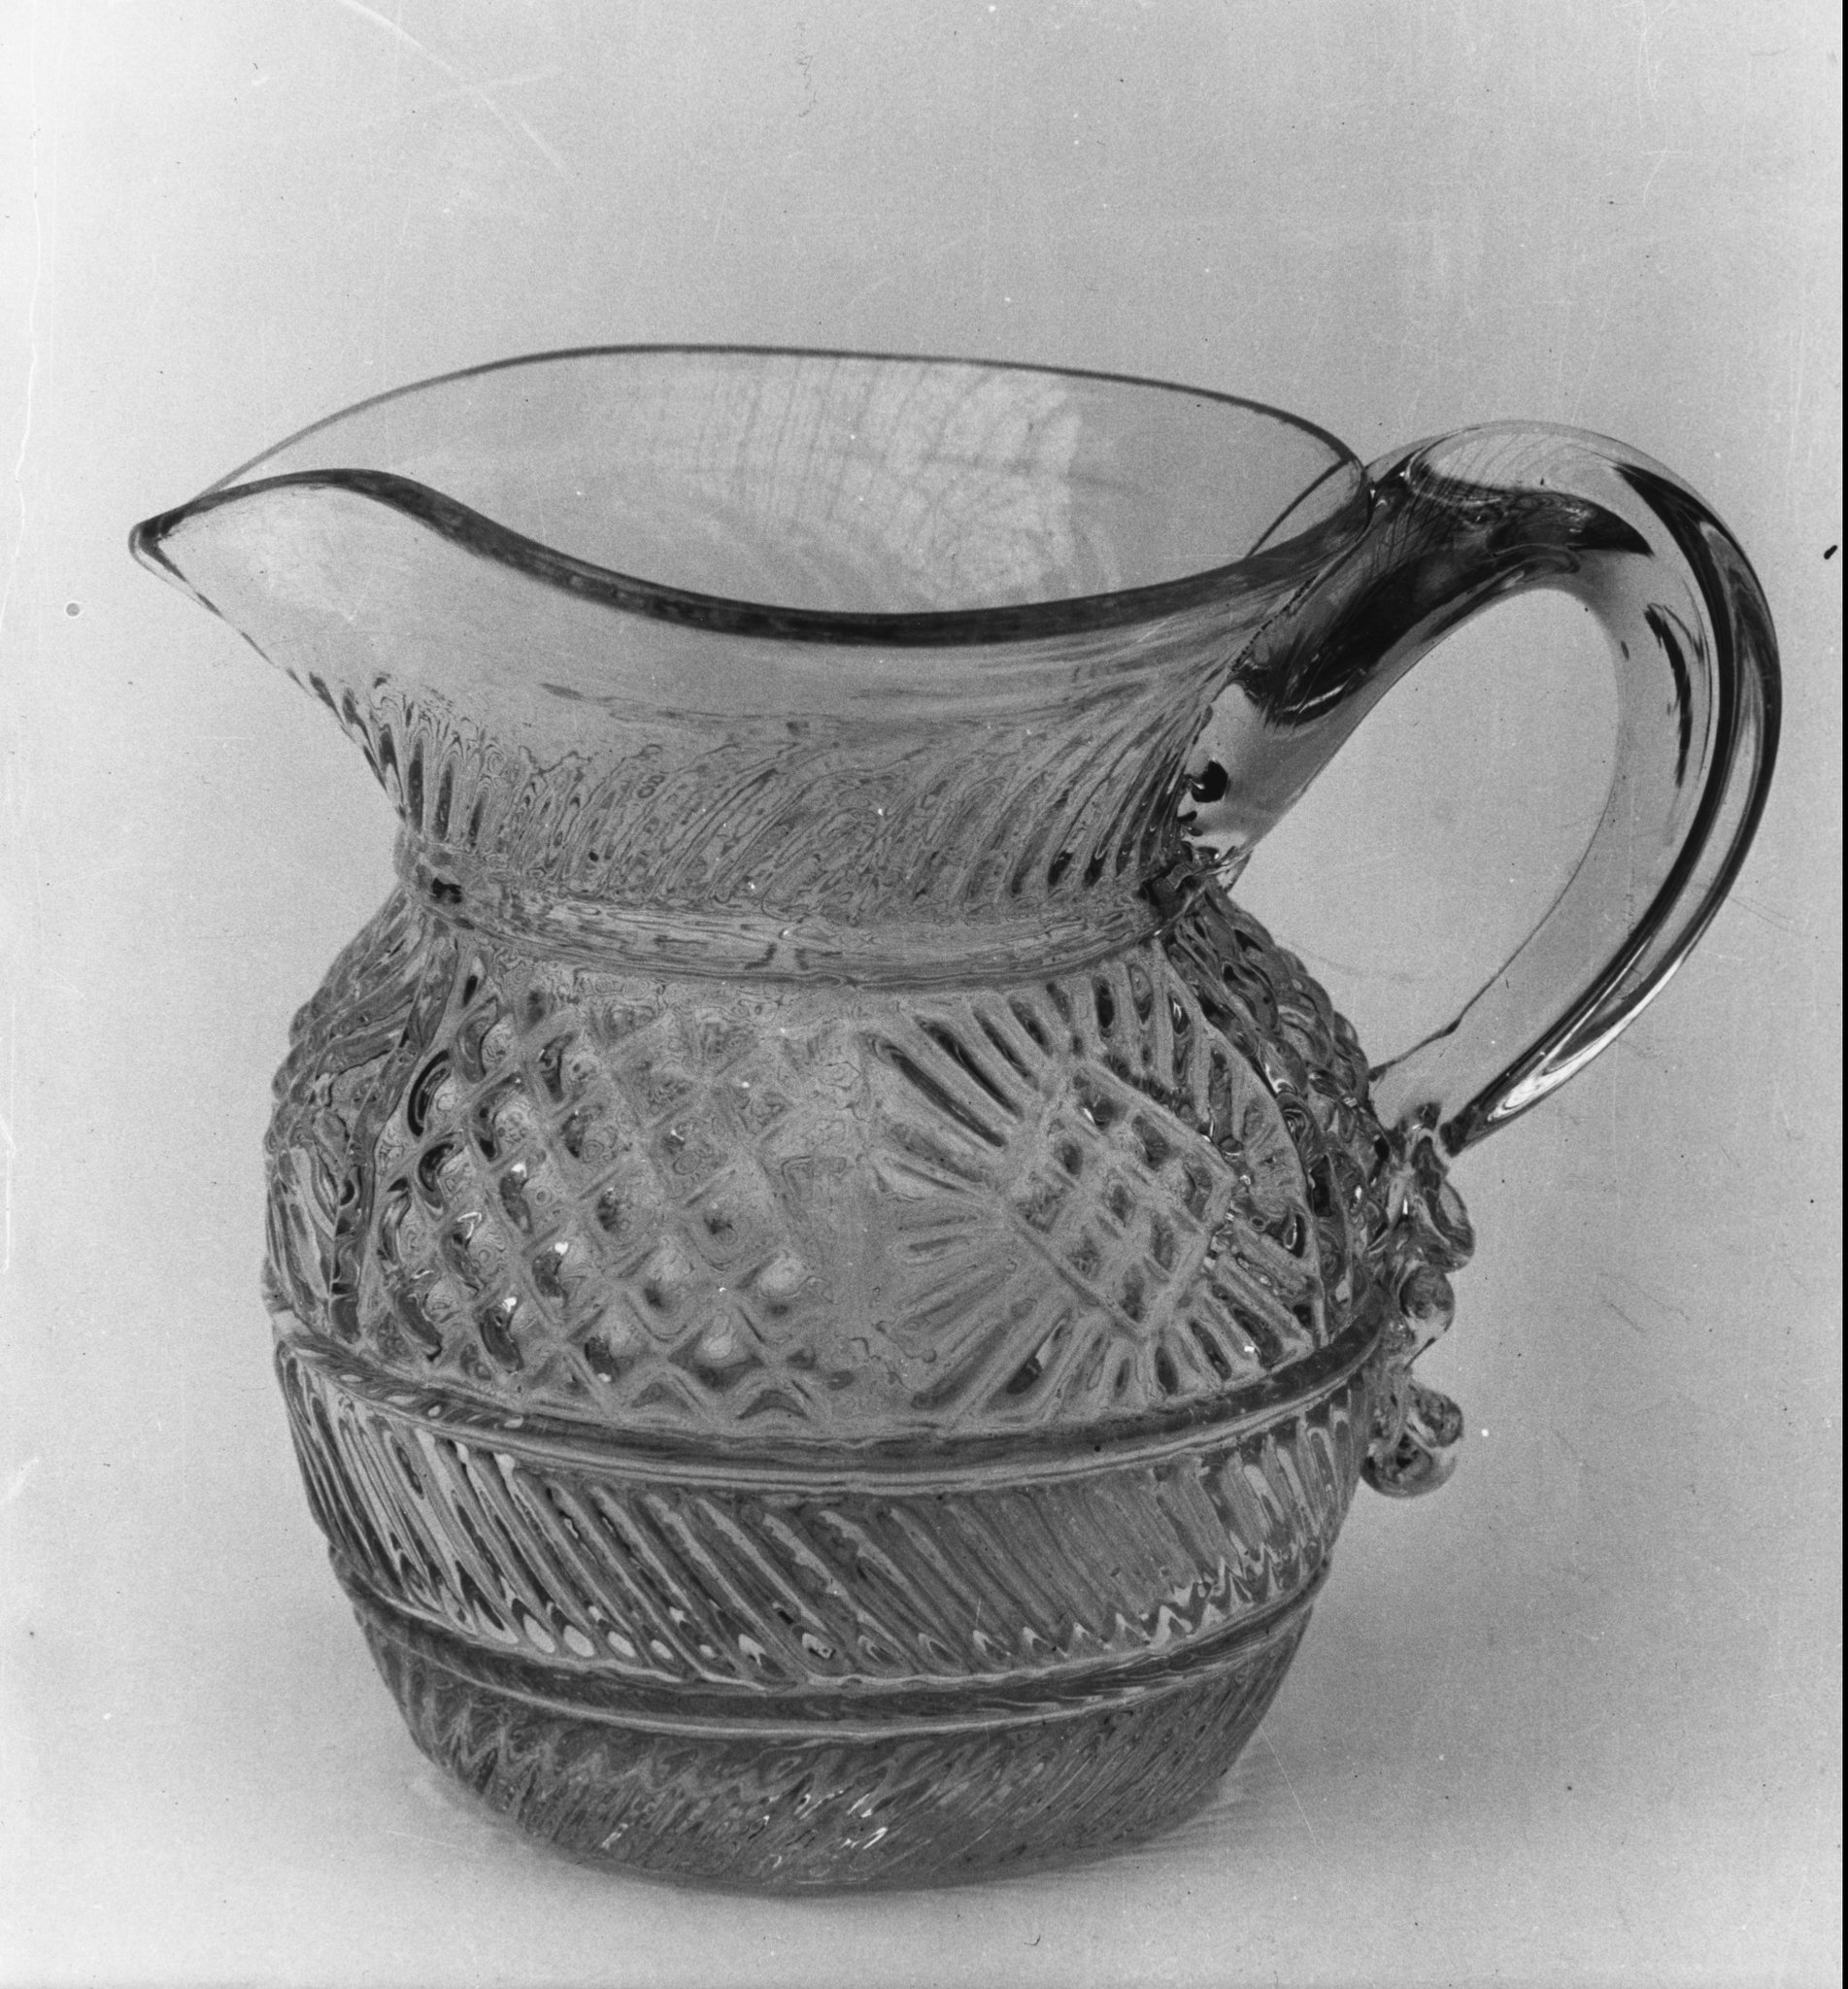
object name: pitcher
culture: american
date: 1820-1840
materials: glass, lead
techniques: glassblowing, molding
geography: united states